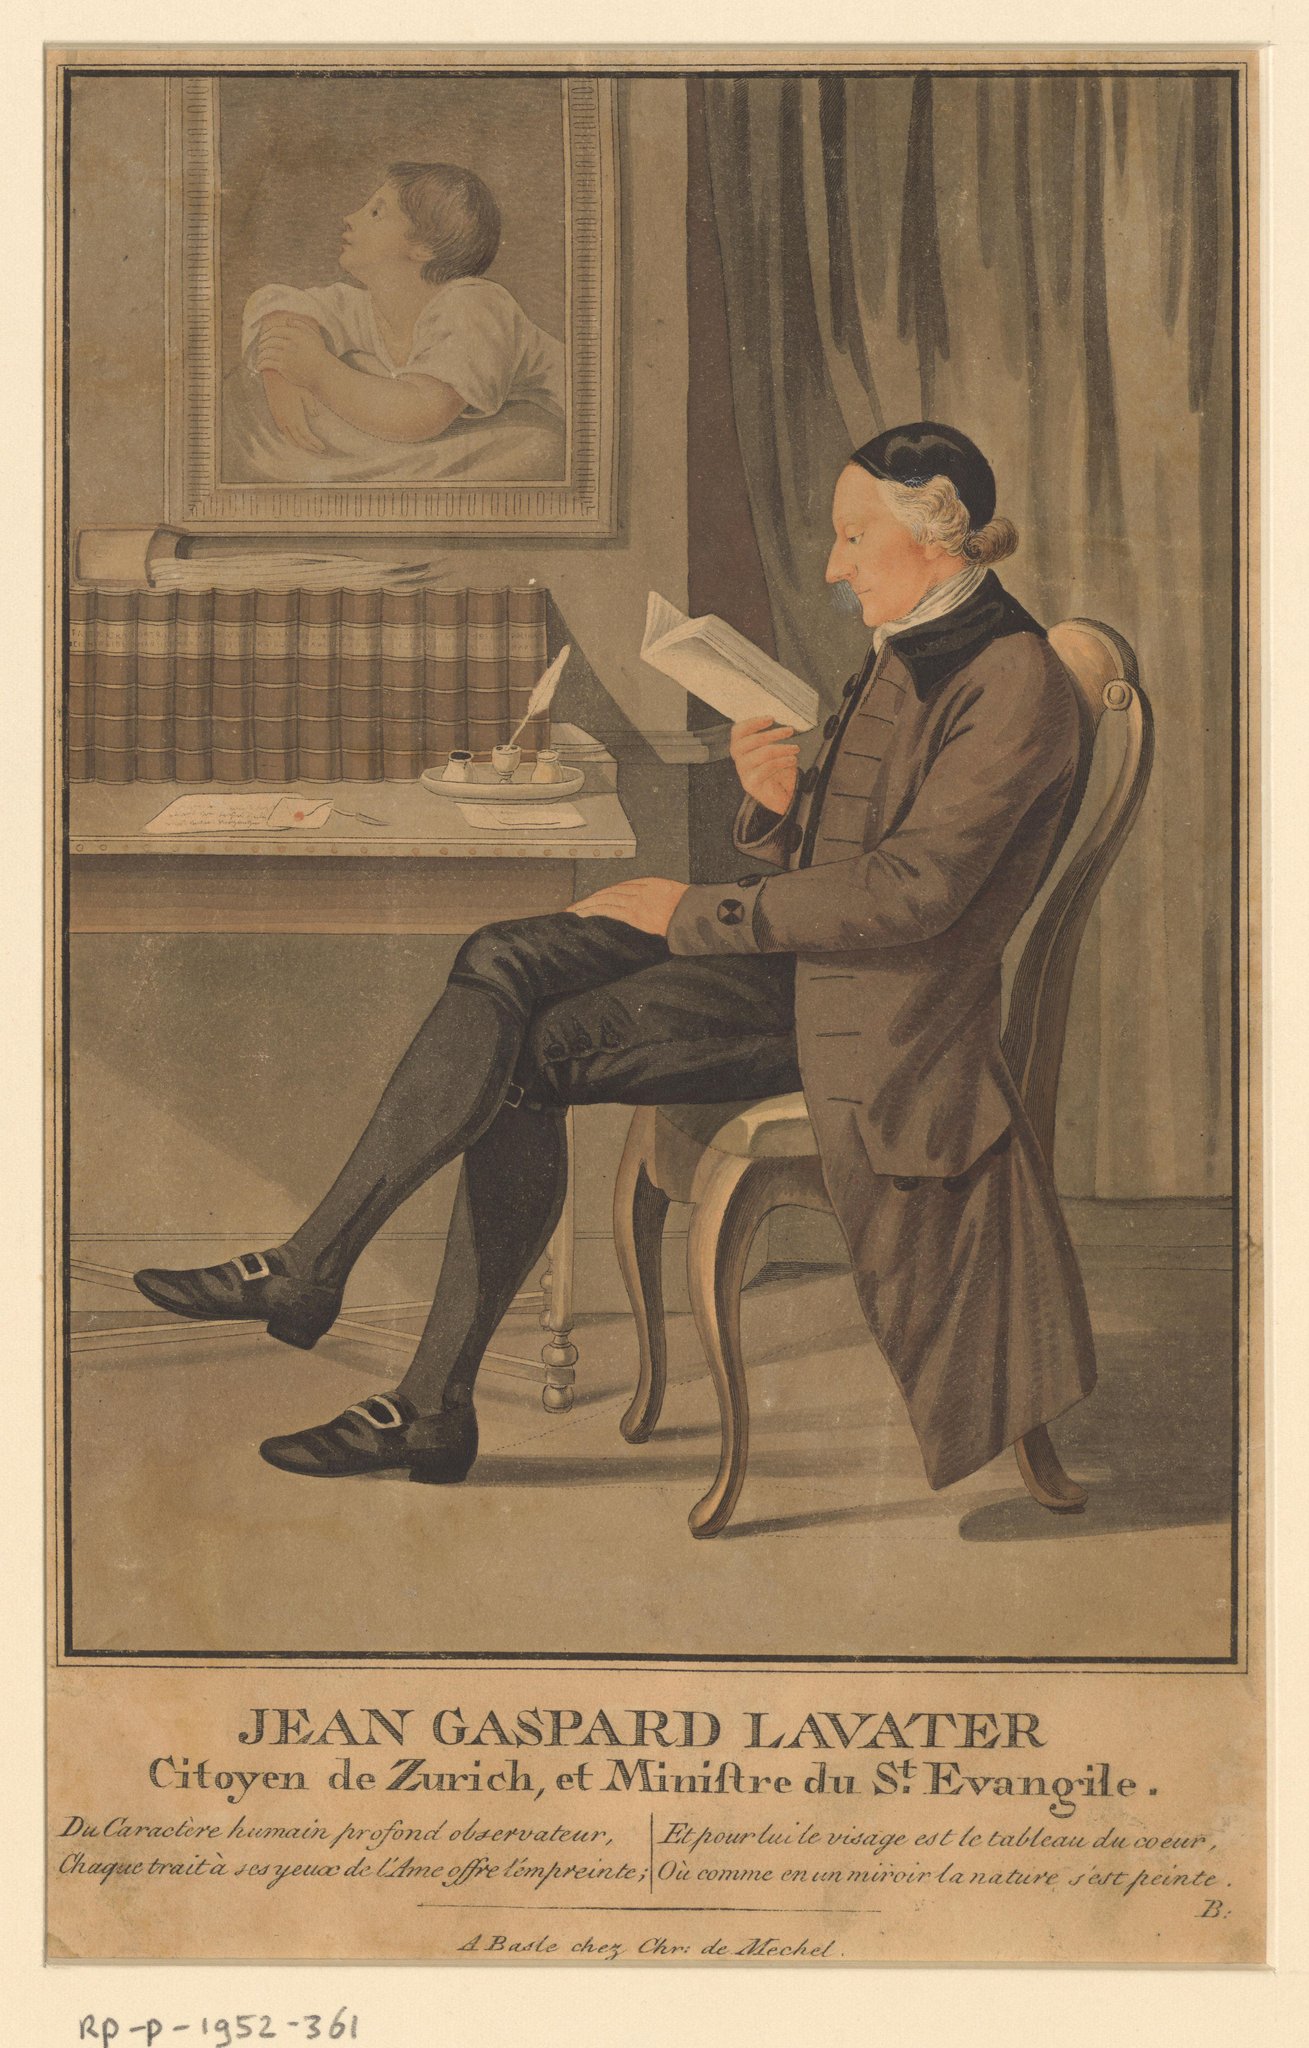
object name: print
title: Portret van Johann Caspar Lavater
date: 1790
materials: paper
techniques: etching, hand coloring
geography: basel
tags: johann caspar lavater, reading, writing tools, historical persons, book, picture, painting, chair, scholar, philosopher (+ portrait of scholar, scientist)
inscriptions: collector's mark: Lugt 2228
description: Portret van de Johann Caspar Lavater, zittend op een stoel. Hij draagt een kalot en een kniebroek en leest een boek. Naast hem een tafel met daarop boeken, een envelop en schrijfgerei. Boven de tafel hangt een schilderij van een jongen. Onder de afbeelding een vierregelige Franse tekst in twee kolommen. Rechtsonder gemerkt: B:.